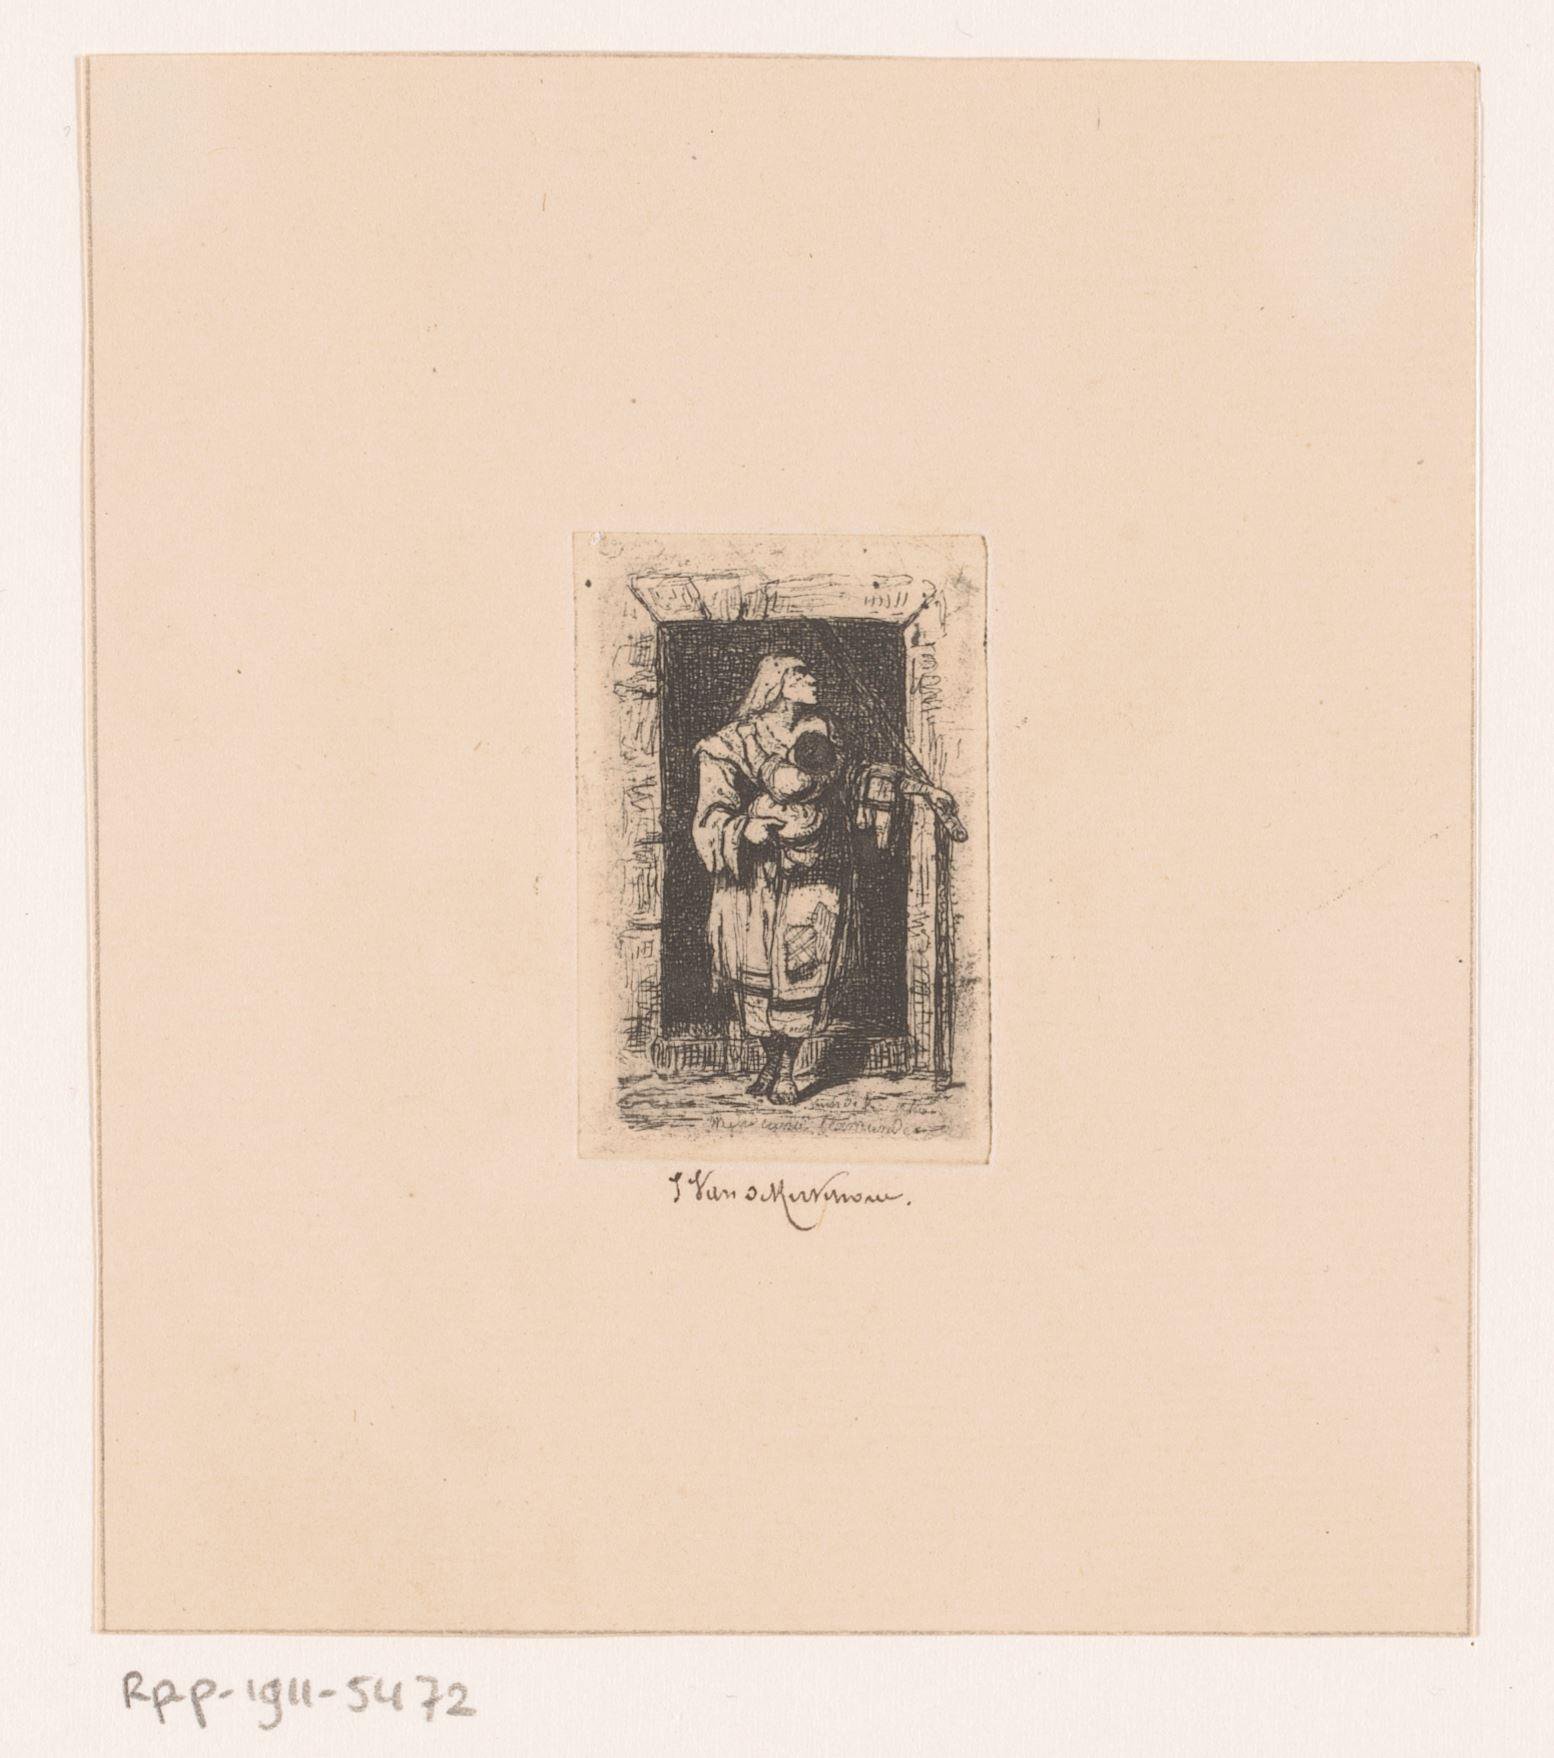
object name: print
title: Mère [...] Flamande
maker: jan van de kerkhove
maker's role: print maker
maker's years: 1822-1881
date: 1832-1881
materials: paper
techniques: etching, intaglio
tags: open door, mother and baby or young child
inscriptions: collector's mark: Lugt 2228